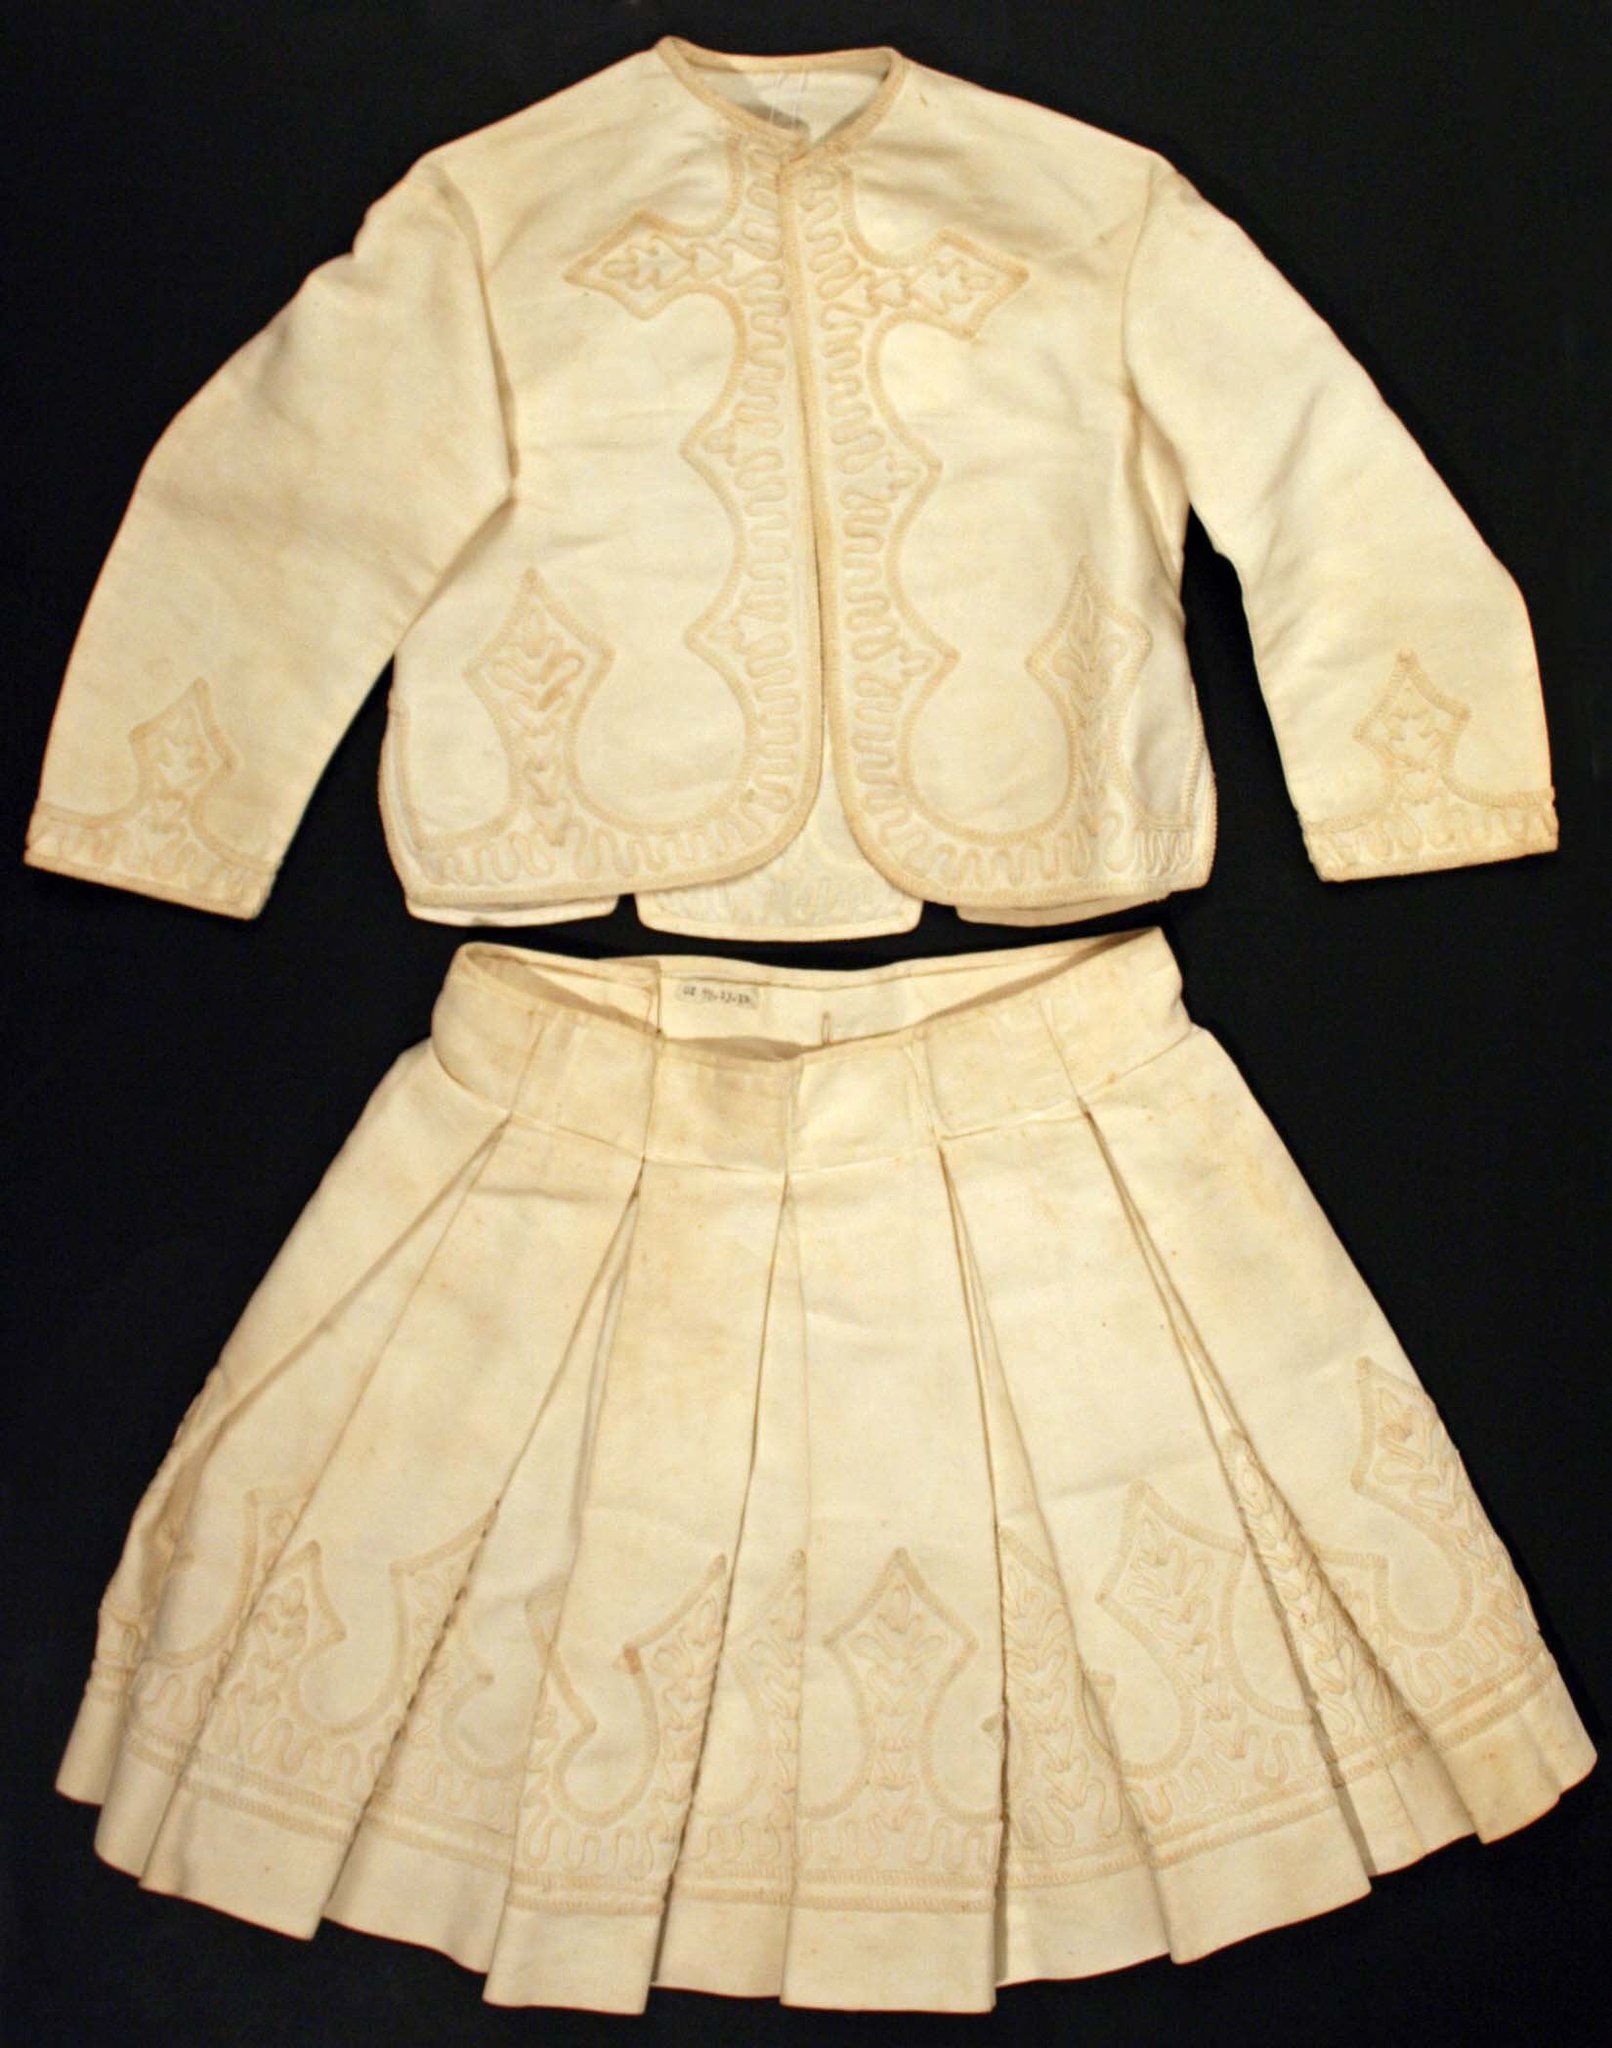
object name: dress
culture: american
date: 1872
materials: cotton